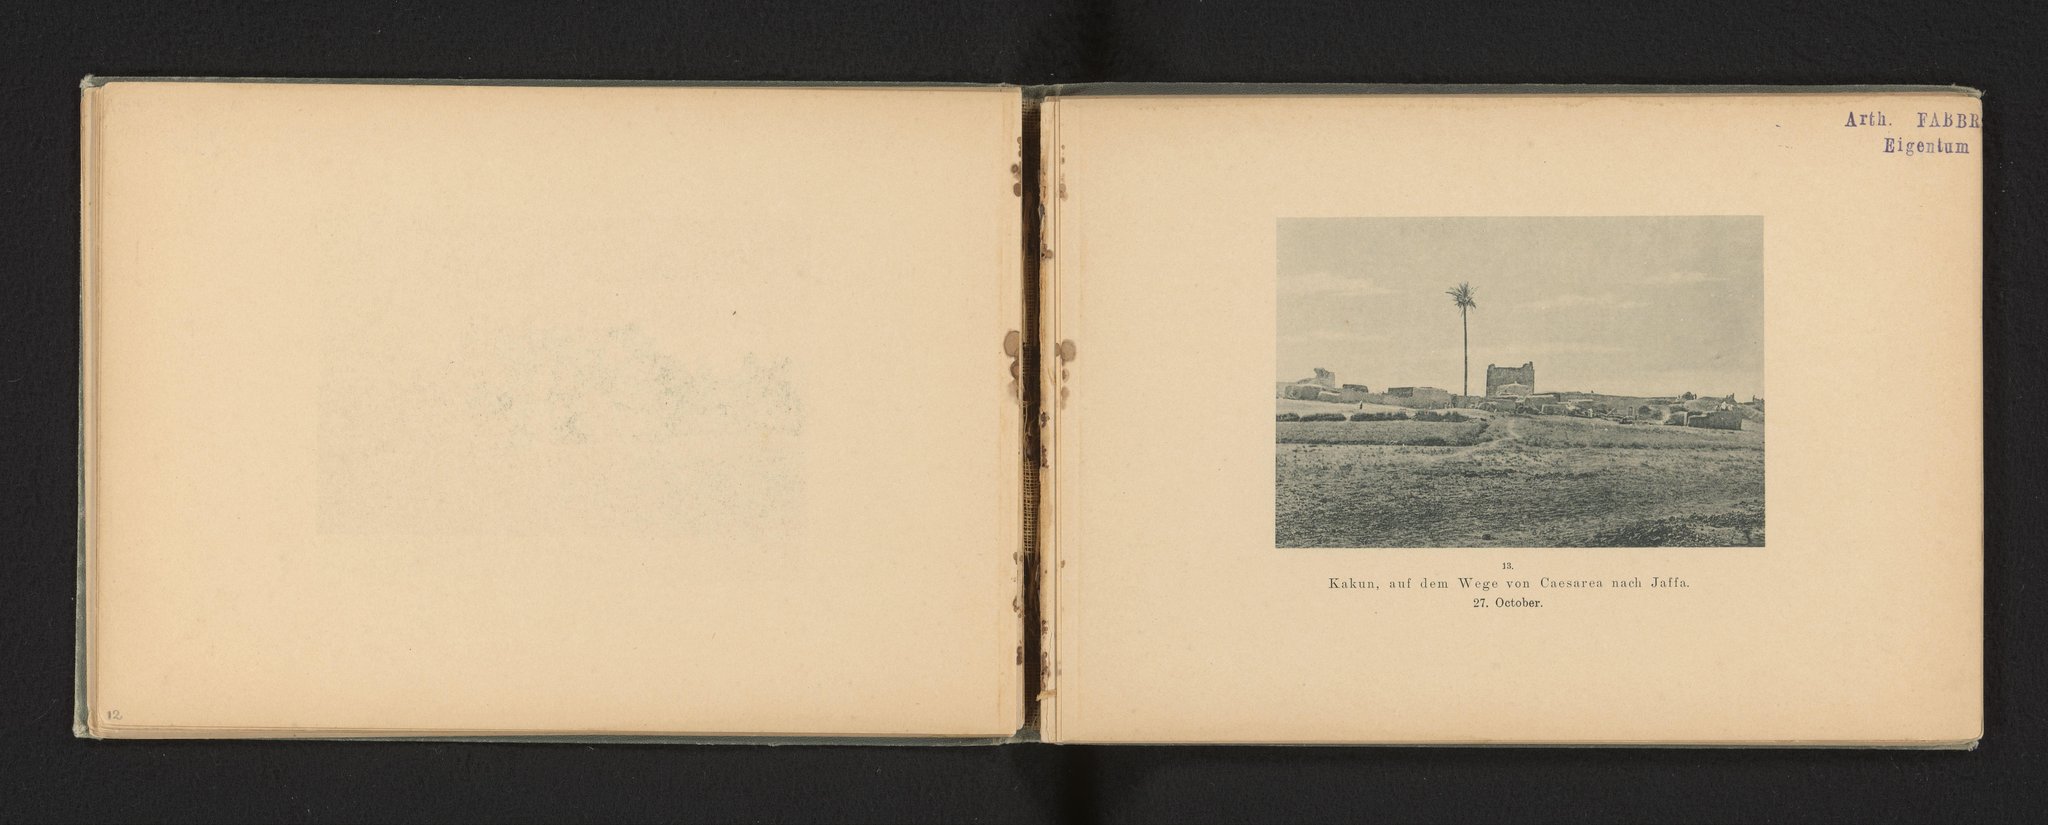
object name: photomechanical print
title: Gezicht op Kakun, op de weg van Caesarea naar Jaffa, Israël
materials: paper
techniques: photograph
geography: palestine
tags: prospect of village, silhouette of village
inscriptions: number: ‘13.’, collector's mark: ‘Arth. FABBR[I]/ Eigentum’